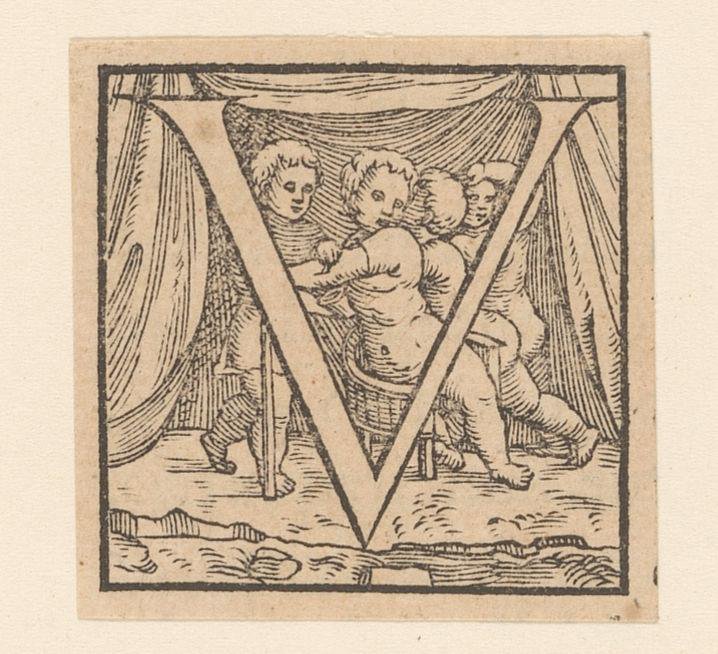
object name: book illustration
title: Letter V: kinderen verbinden de arm van een kind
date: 1543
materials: paper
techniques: woodcut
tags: letters, alphabet, script, physiology and anatomy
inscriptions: collector's mark: Lugt 2227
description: Prent uit: Vesalius, Andreas. De Humani Corporis Fabrica. Bazel: Jan Herpst, 1543.